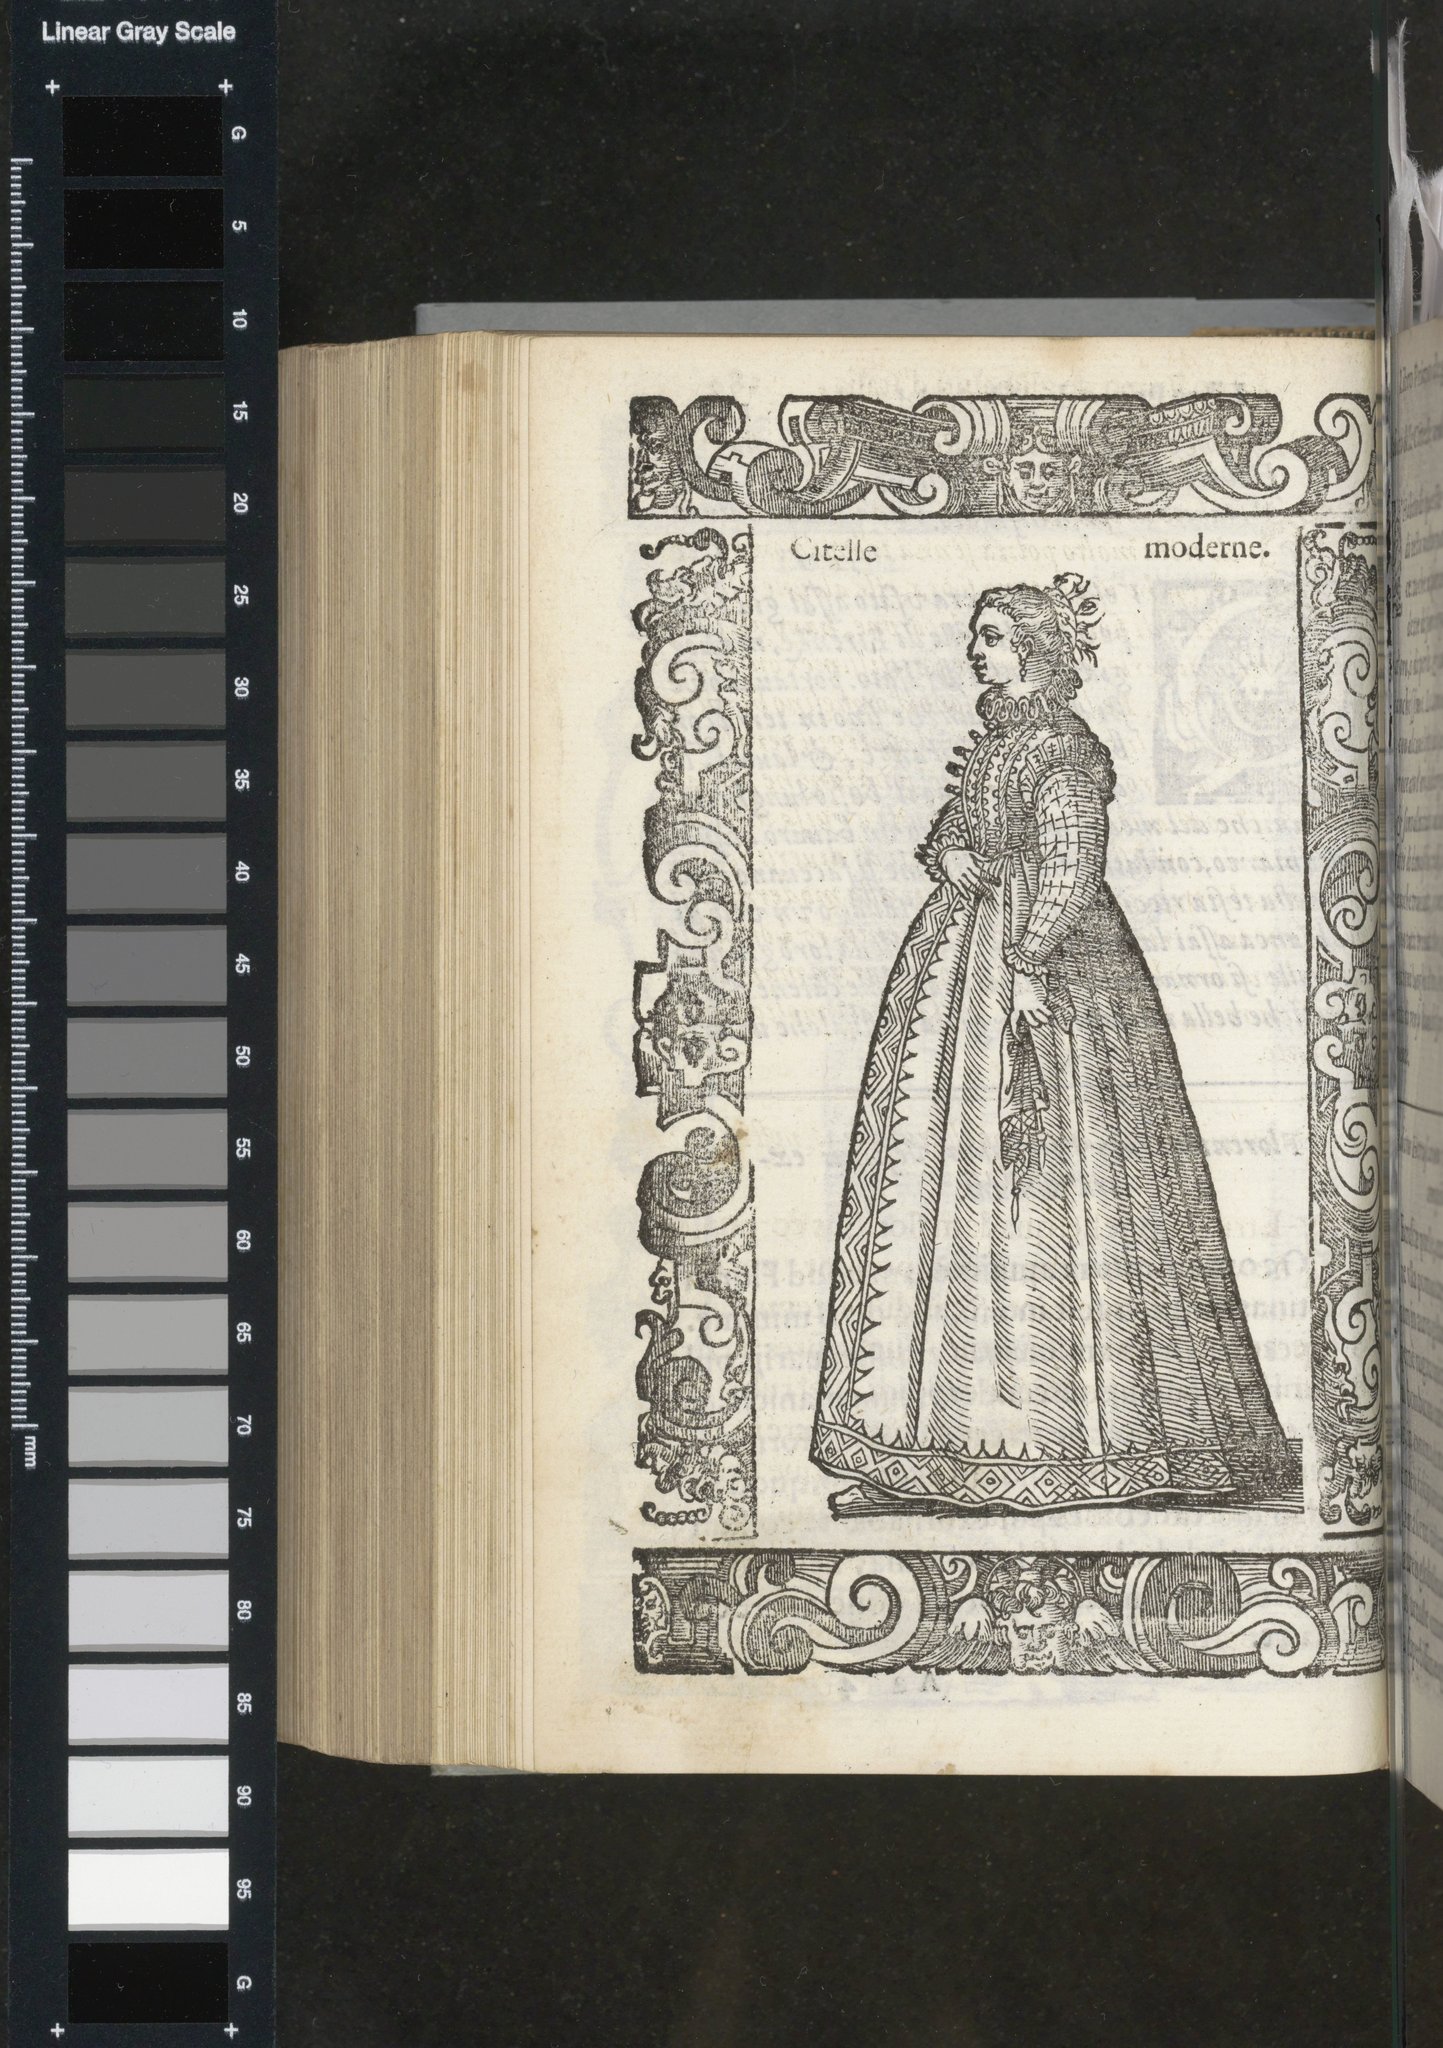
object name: costume print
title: Habiti antichi, et moderni di tutto il mondo...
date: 1598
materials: paper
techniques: woodcut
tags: ear-rings (+ women's clothes), handkerchief (+ women's clothes), neck-gear: collar (+ women's clothes), fashion plates, dress, gown (+ women's clothes), clothing for the upper part of the body (with name) (+ women's clothes)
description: Volgens de tekst van Vecellio verl;aten ongetrouwde meisjes uit Topscane nooit het huis, behalve om naar de kerk te gaan (bv. met Pasen). Hun kapsel is eenvoudig maar elegant en is versierd met een bloemenkransje. Ze dragen gouden oorbellen. Rok van witte of rode 'ormesino' , bevestigd aan een lijfje van damast, satijn of brokaat, afgezet met kant. Neusdoek (zakdoek) in de hand. (Onder naam “Nobile Firentina”)